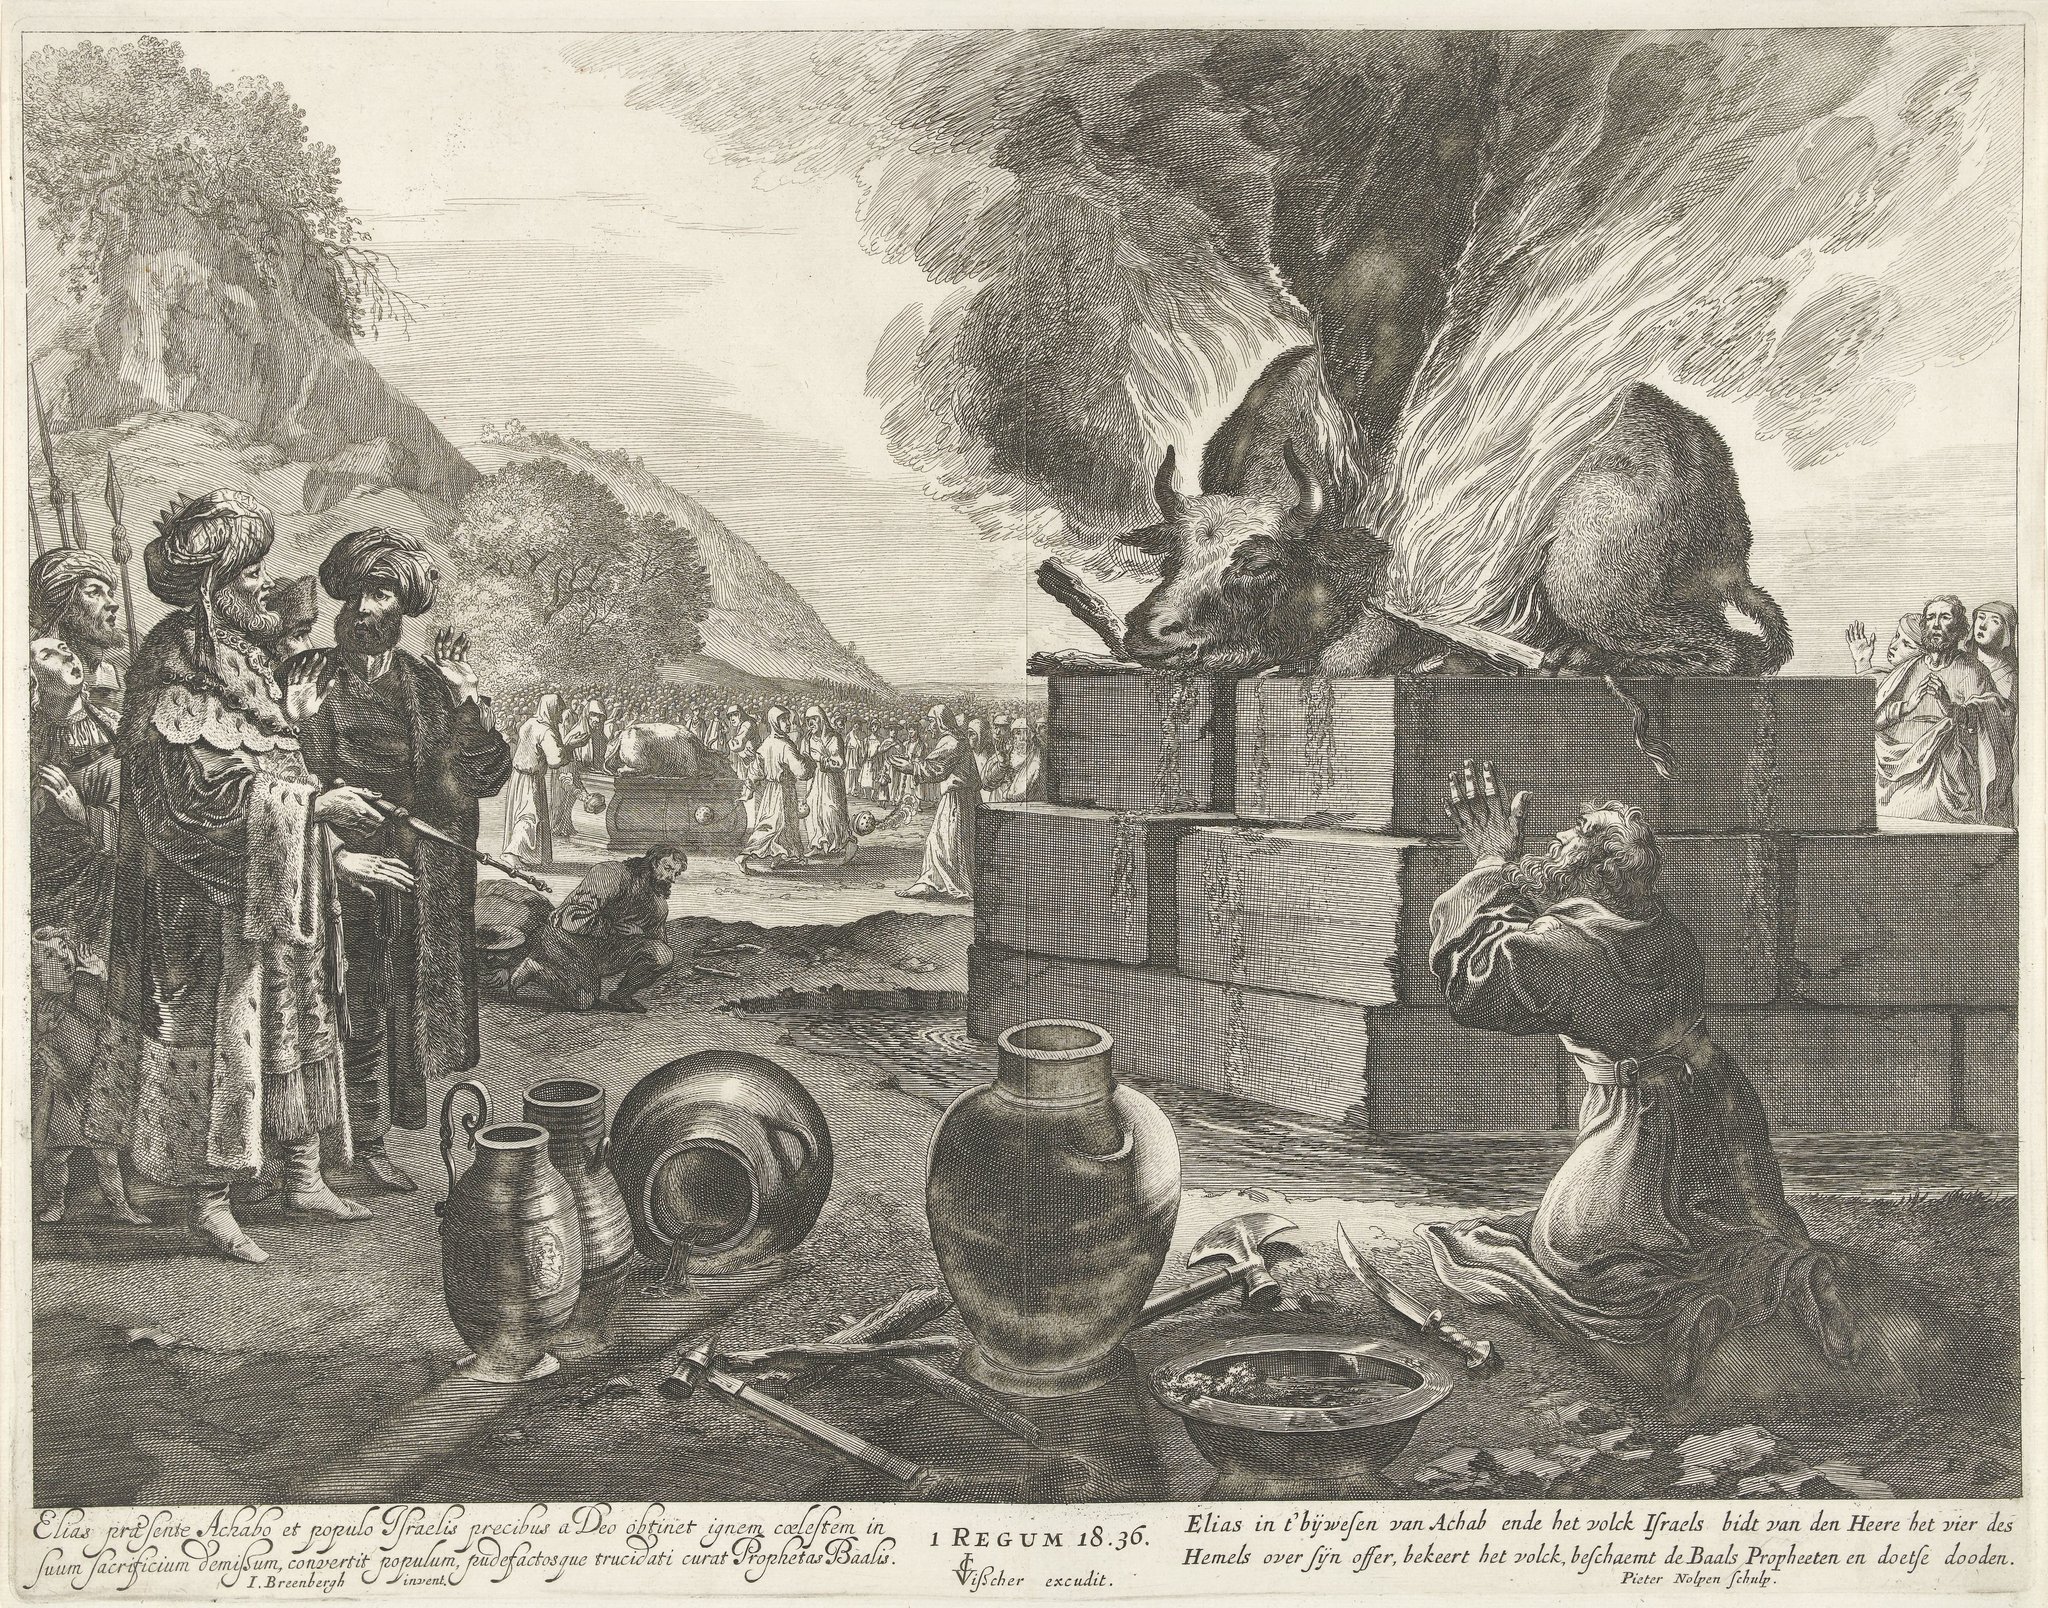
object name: print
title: Elia en de profeten van Baäl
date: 1623-1653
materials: paper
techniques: engraving, etching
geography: amsterdam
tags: as elijah prays, god sends fire which burns up not only his sacrifice but also the altar itself; the people fall prostrate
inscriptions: collector's mark: Lugt 2228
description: De profeet Elia knielt voor het altaar dat hij met water heeft overgoten en roept zijn God aan om het offer te laten branden. Links kijkt koning Achab toe. Op de achtergrond staan de priesters van Baäl bij hun altaar, waar zij vergeefs Baäl aanroepen om hun offer te verbranden. Onderaan in de marge een tweeregelige tekst in het Latijn en een tweeregelige tekst in het Nederlands en in het midden de verwijzing naar de bijbeltekst in 1 Kon. 18: 36.